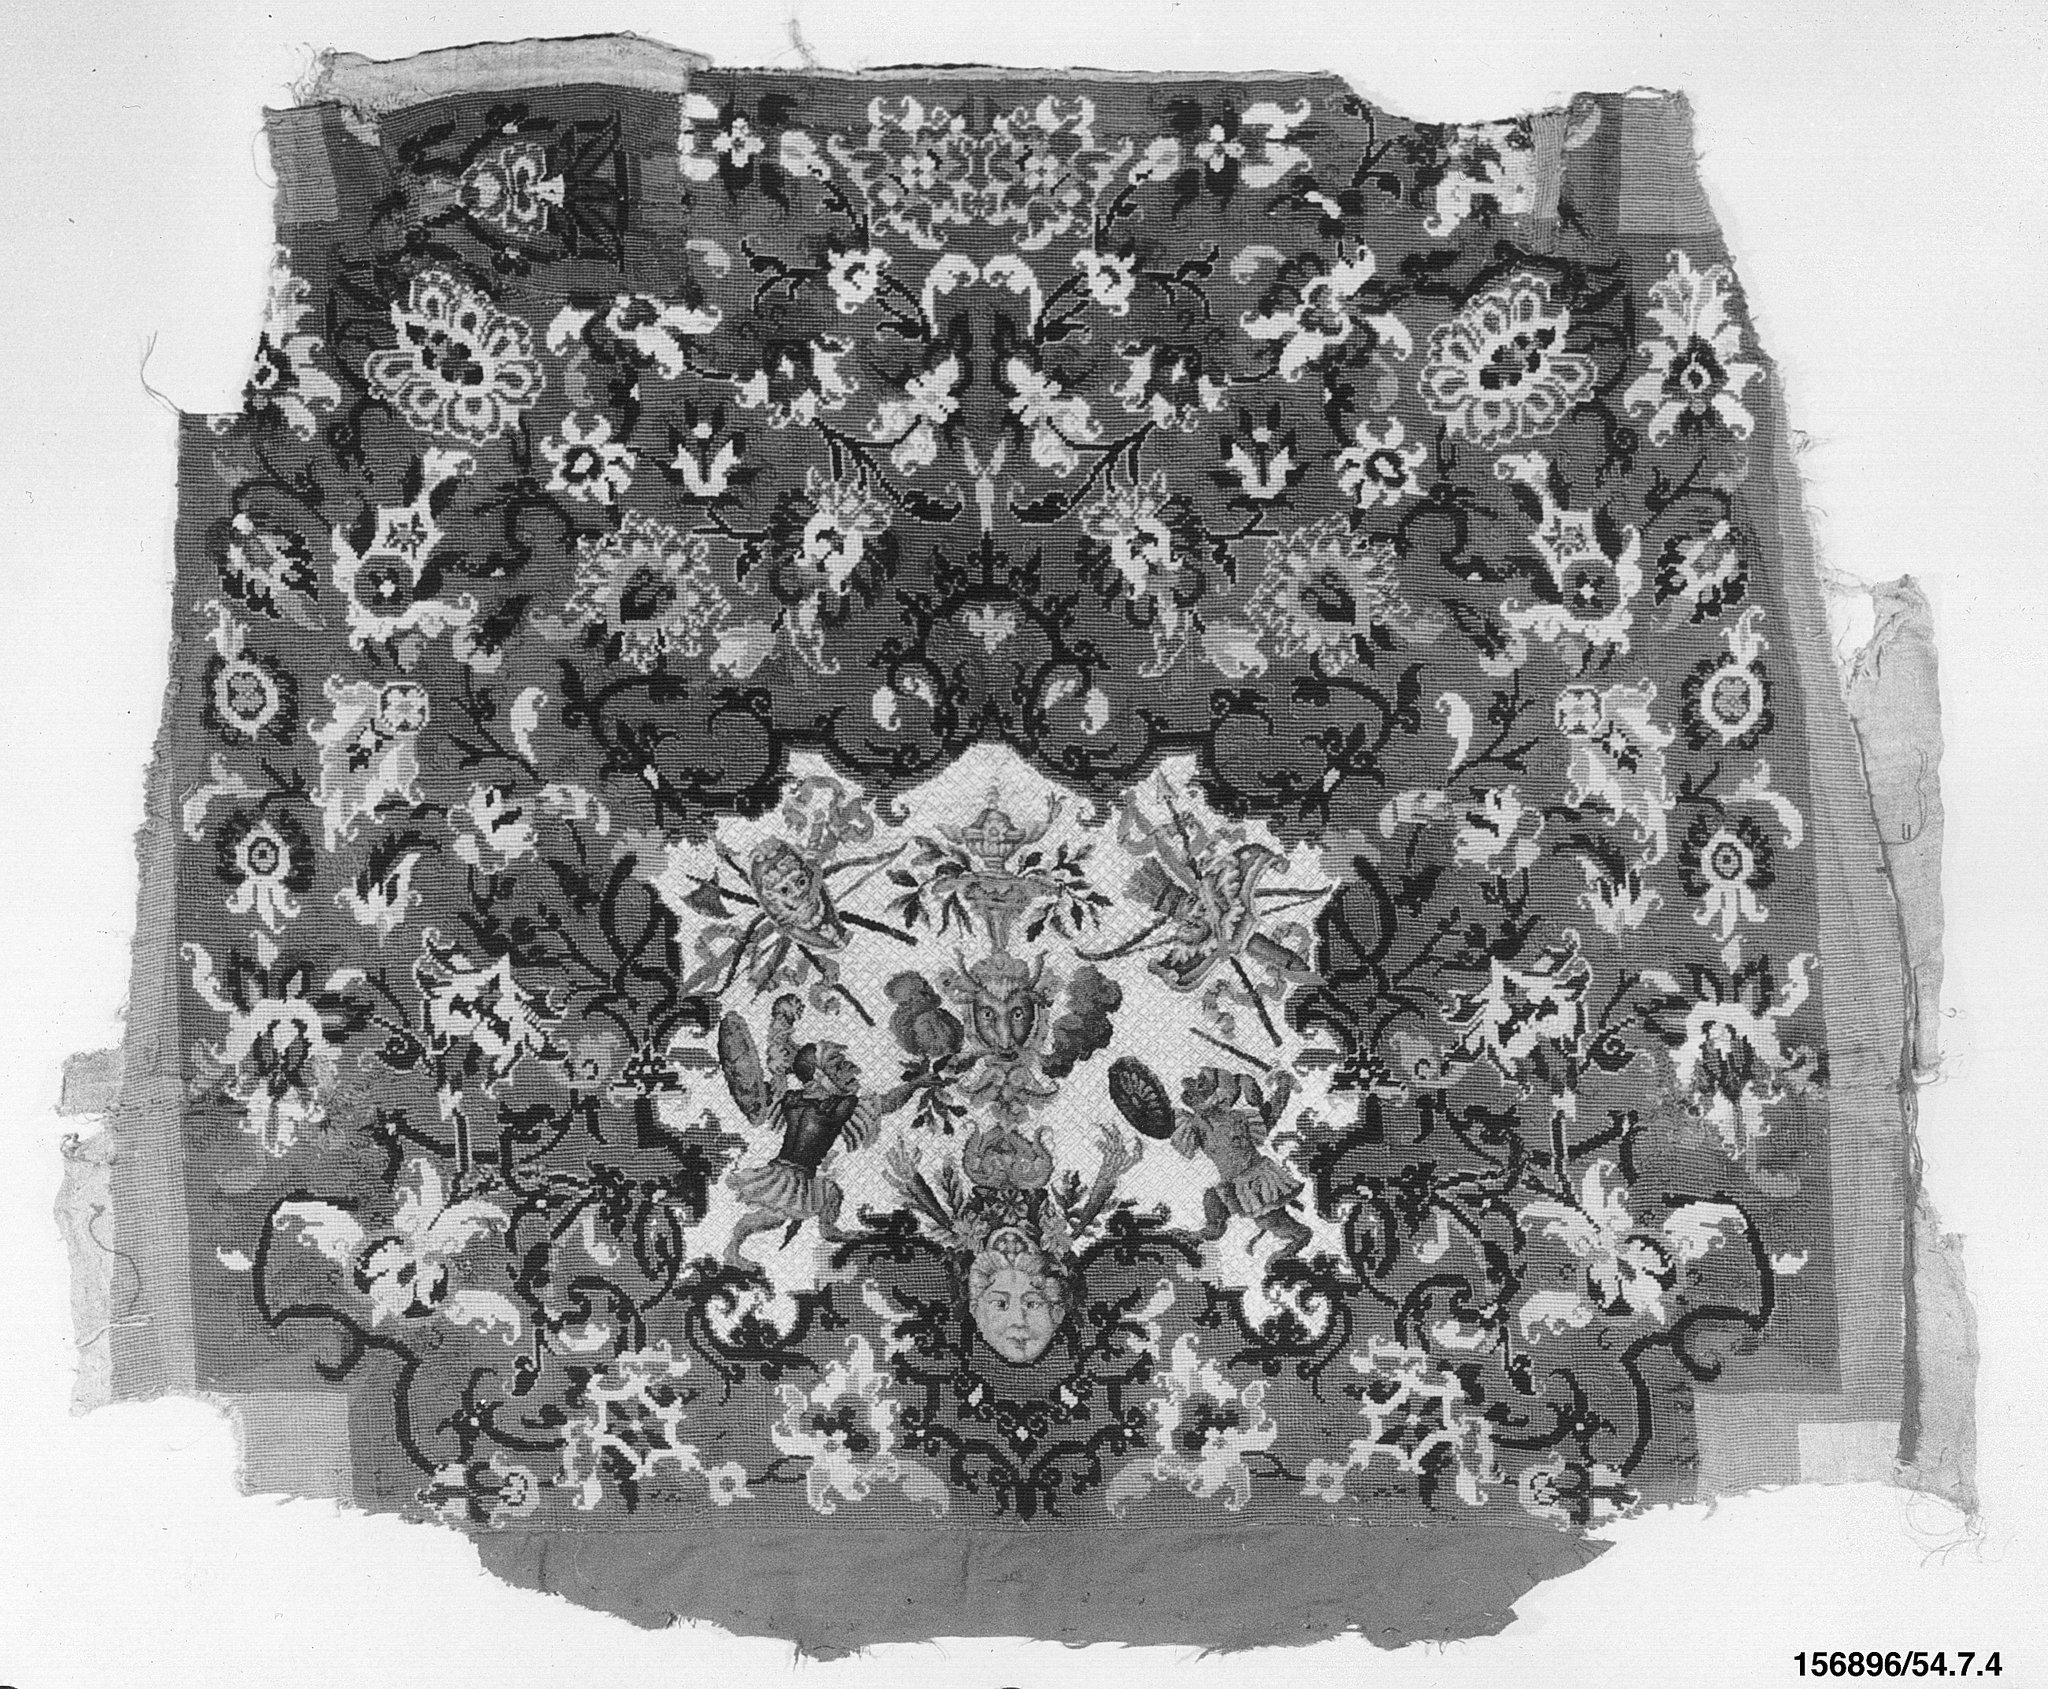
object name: panel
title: Chair seat cover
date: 1701-1750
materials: canvas, silk, wool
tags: flowers